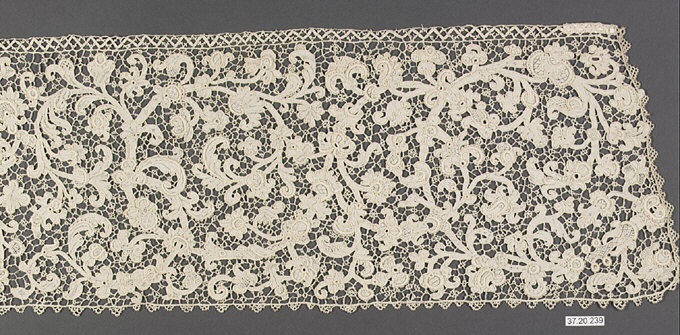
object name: border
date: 1601-1700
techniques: lace